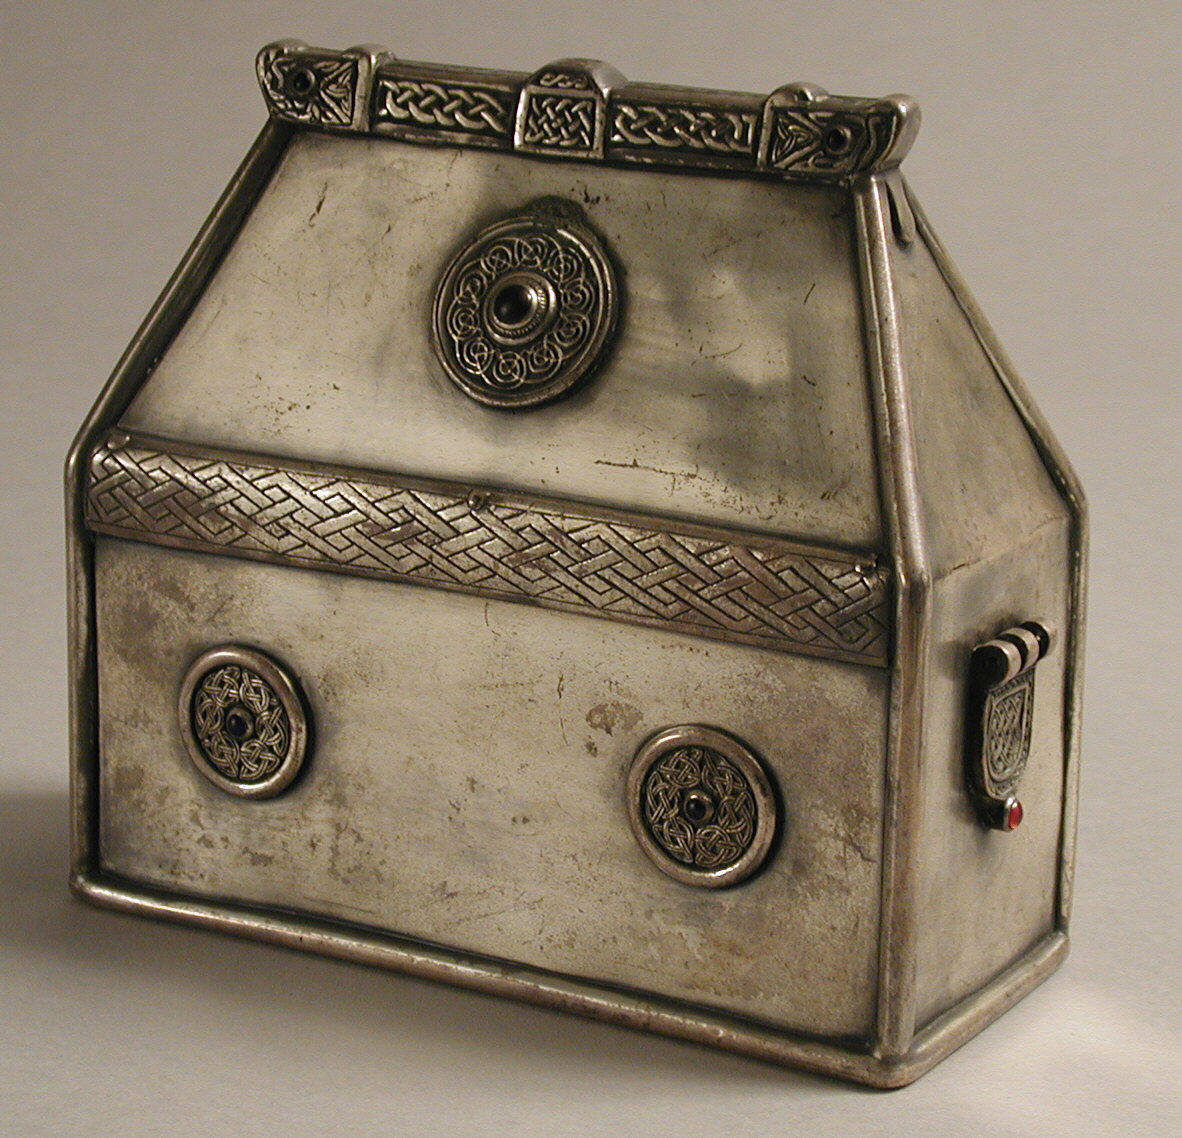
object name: shrine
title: Lough Erne Shrine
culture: irish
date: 1901-1933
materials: silver